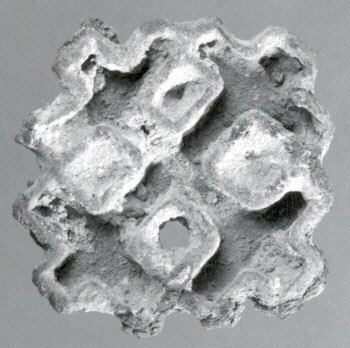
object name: stamp seal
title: Compartmented stamp seal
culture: bactria-margiana archaeological complex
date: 2333-1668 BCE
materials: copper alloy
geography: bactria-margiana